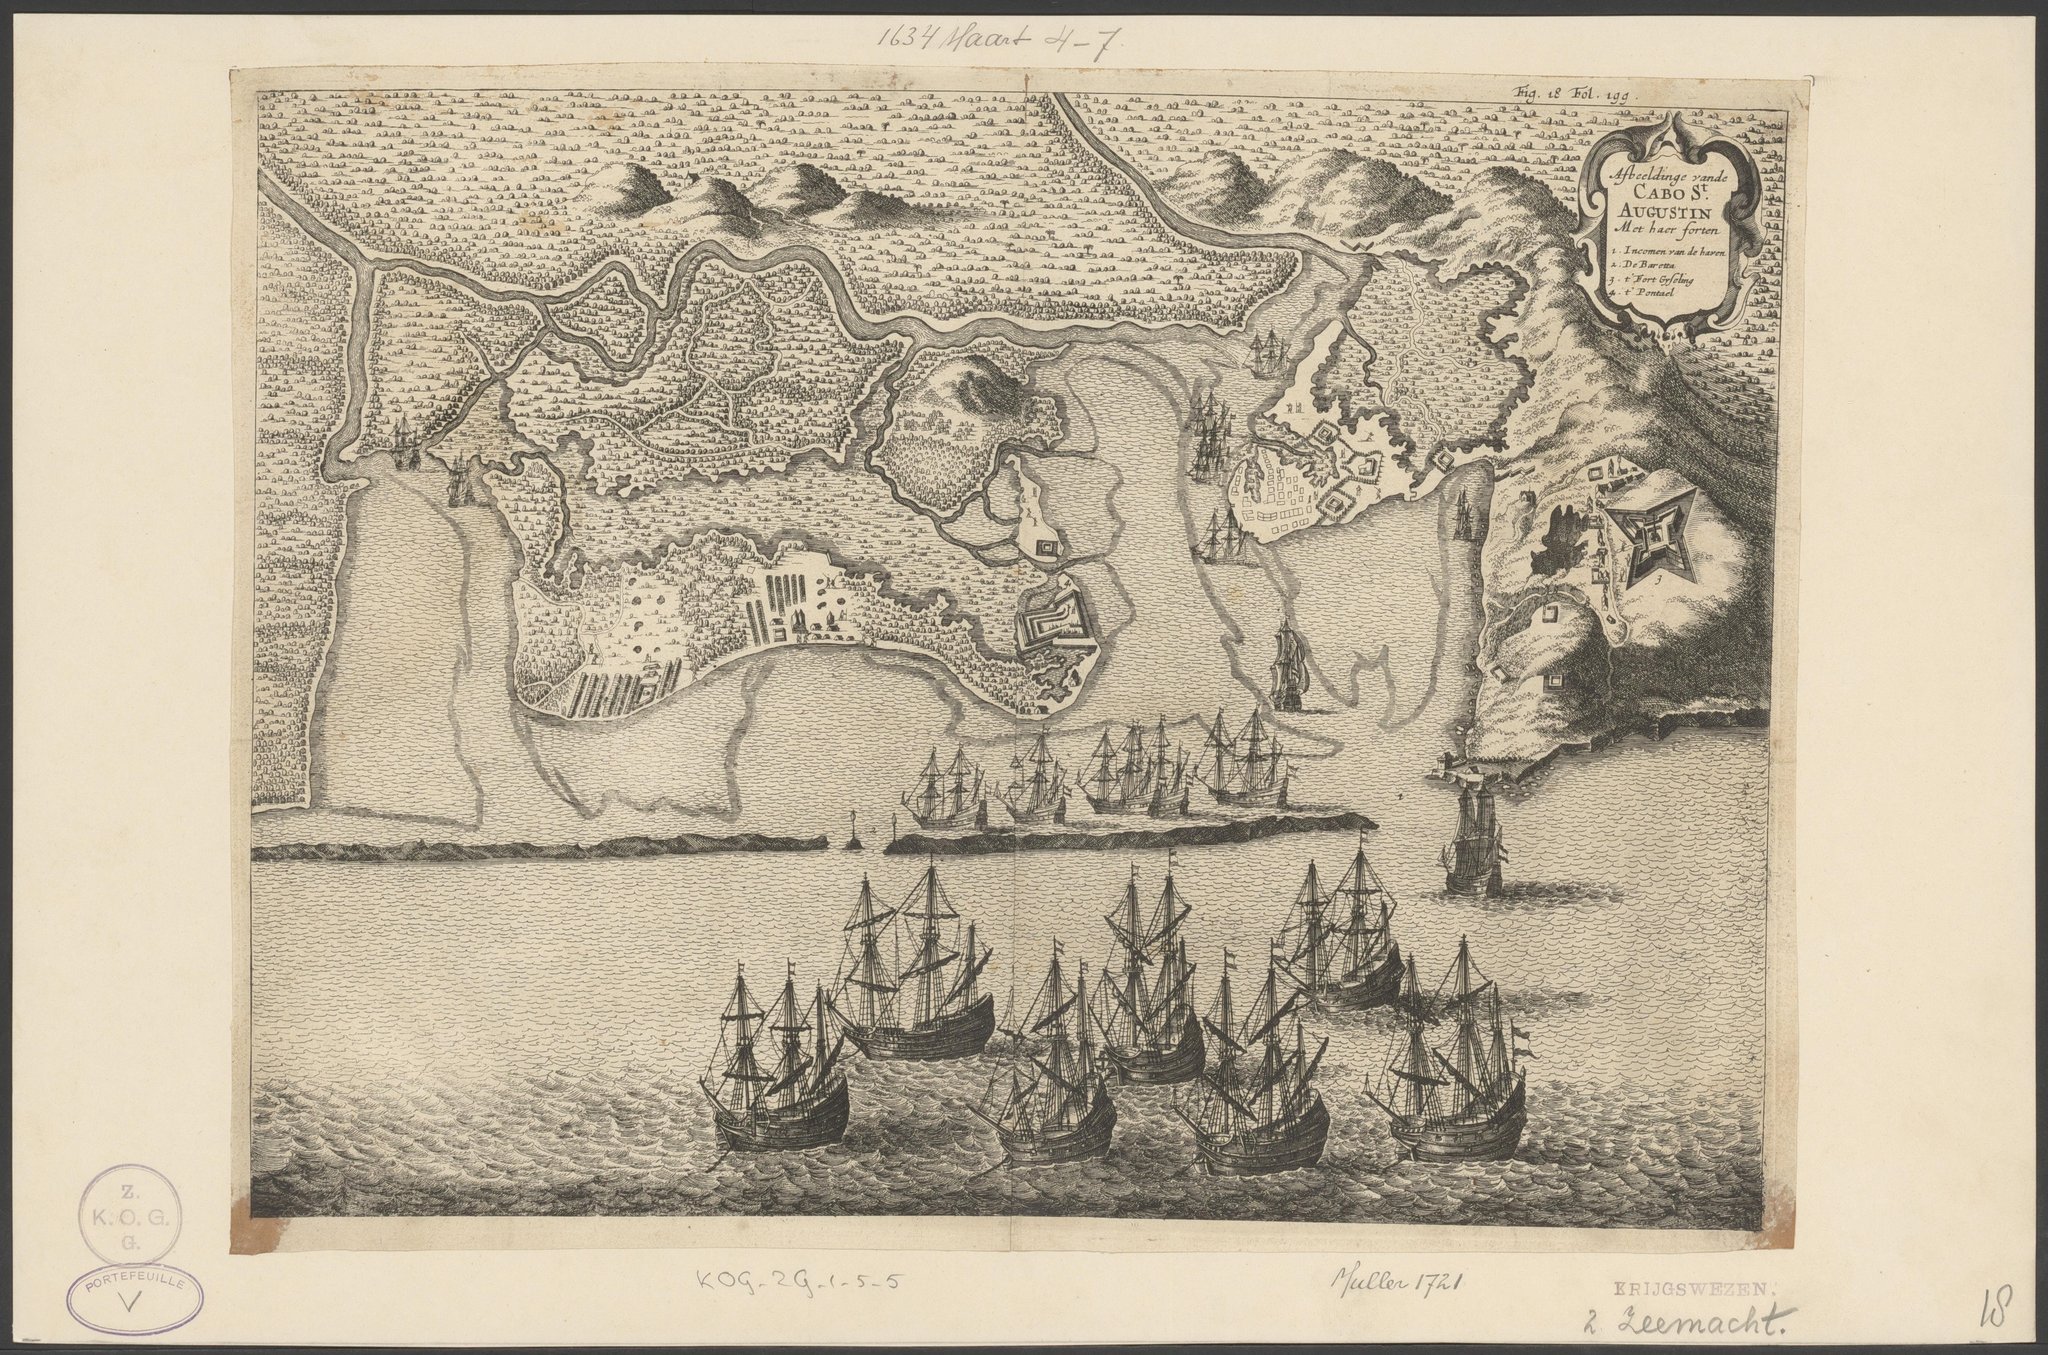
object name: book illustration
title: Afbeeldinge vande Cabo St Augustin Met haer forten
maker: Anonymous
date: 1651-1656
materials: paper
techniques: etching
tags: sailing-ship, sailing-boat, (military) attack (+ sailing-ships)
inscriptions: collector's mark: Lugt 1641, stamp, stamp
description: De vloot van de Nederlanden ligt voor de kaap Cabo de Santo Agostinho in Brazilië. De kaap wordt in vogelvluchtperspectief getoond, waardoor de forten Baretta, Fort Gyseling en Pontael zichtbaar zijn. Rechtsboven genummerd: Fig. 18 Fol. 199. Onderwerpsrubrieken binnen de Atlas Zeden en Gewoonten: Krijgswezen, Zeemacht.